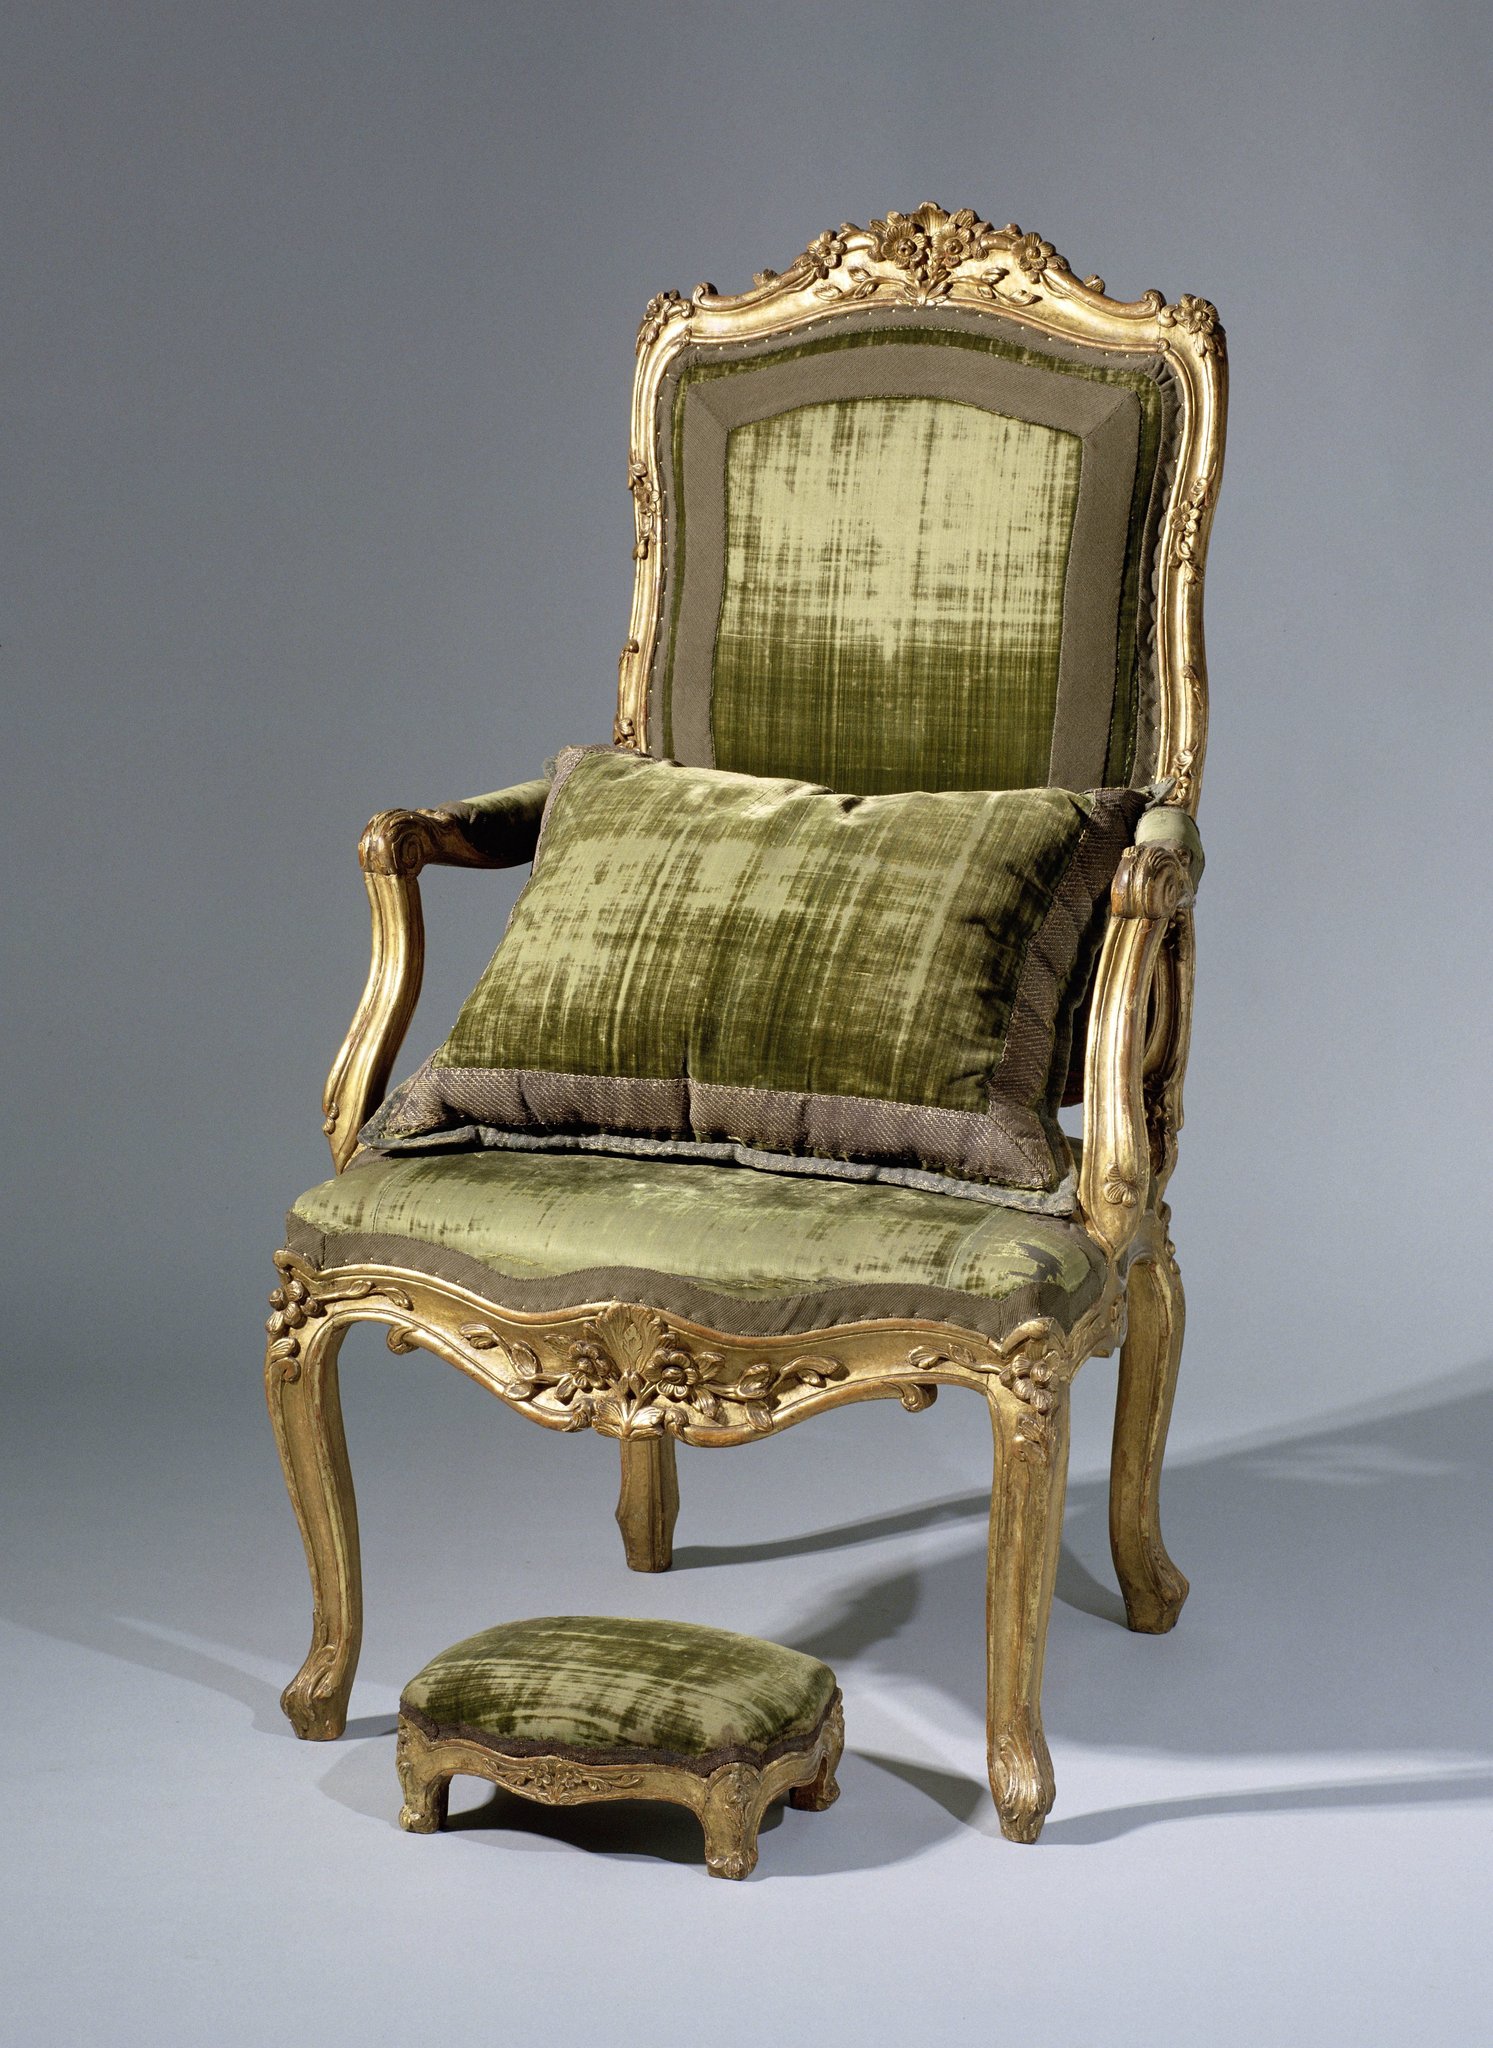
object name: seating furniture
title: Stadhoudersstoel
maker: Anonymous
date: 1768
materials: thread, velvet, wood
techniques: gilding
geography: the hague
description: Stadholder's chair with footstool. Walnut, gilded, upholstered with velvet trimmed with silver and gold braid. Probably The Hague, 1768 (?). The chair, one of a pair, was probably used during the visit of Stadholder Prince William V and his consort, Princess Wilhelmina, to Amsterdam in 1768. On loan from the City of Amsterdam.